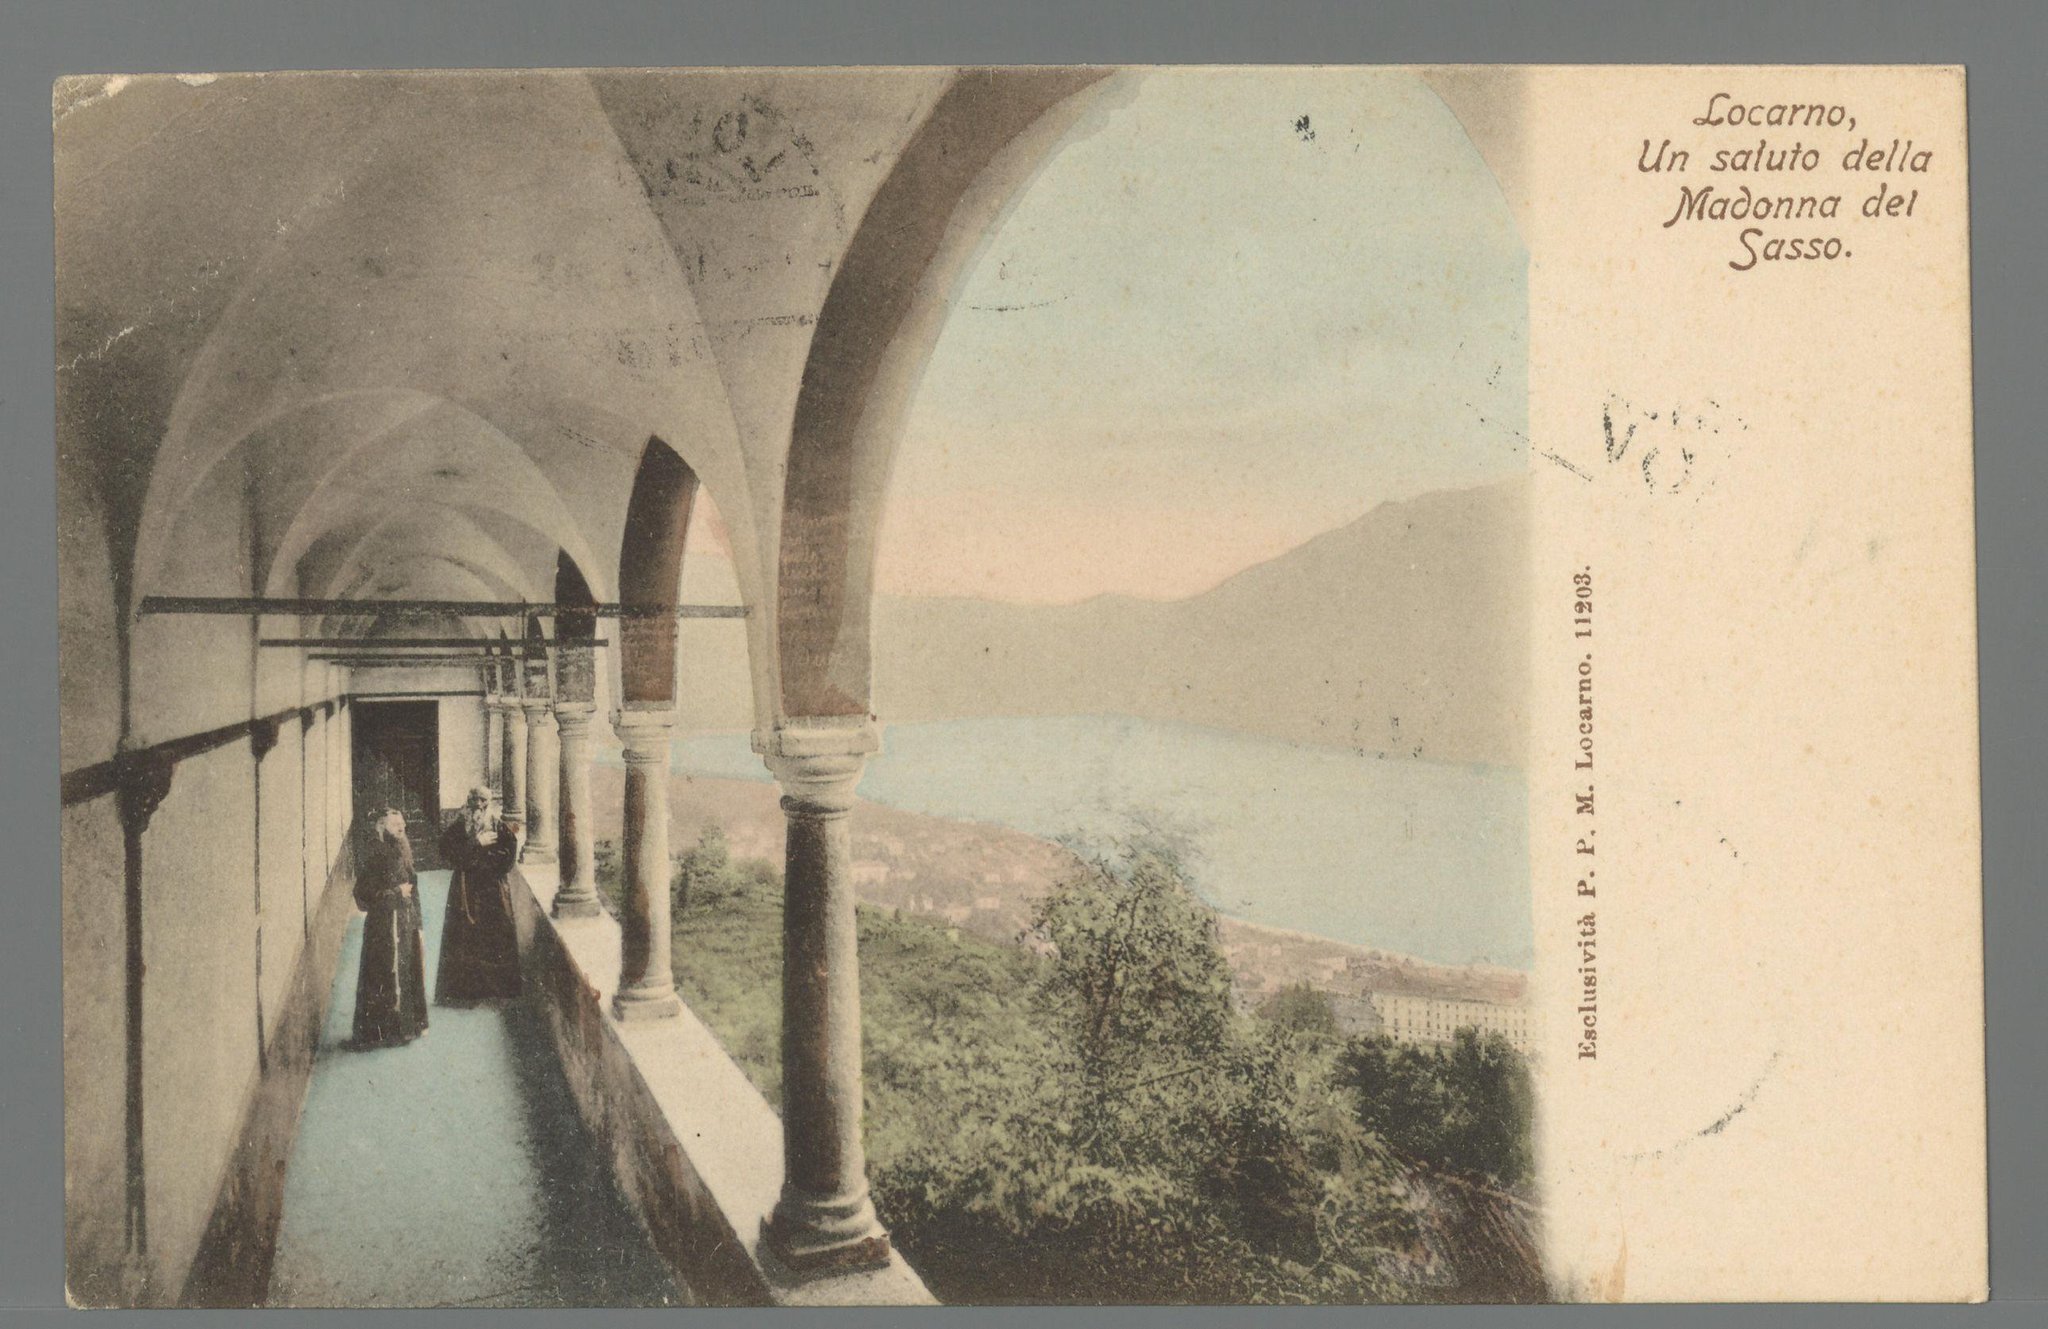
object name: ansichtkaart, prentbriefkaart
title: Locarno. Un saluto della Madonna del Sasso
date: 1890-1902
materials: cardboard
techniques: photograph, lithograph, writing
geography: locarno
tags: abbey, monastery, convent ~ roman catholic church, monk(s), friar(s), lake